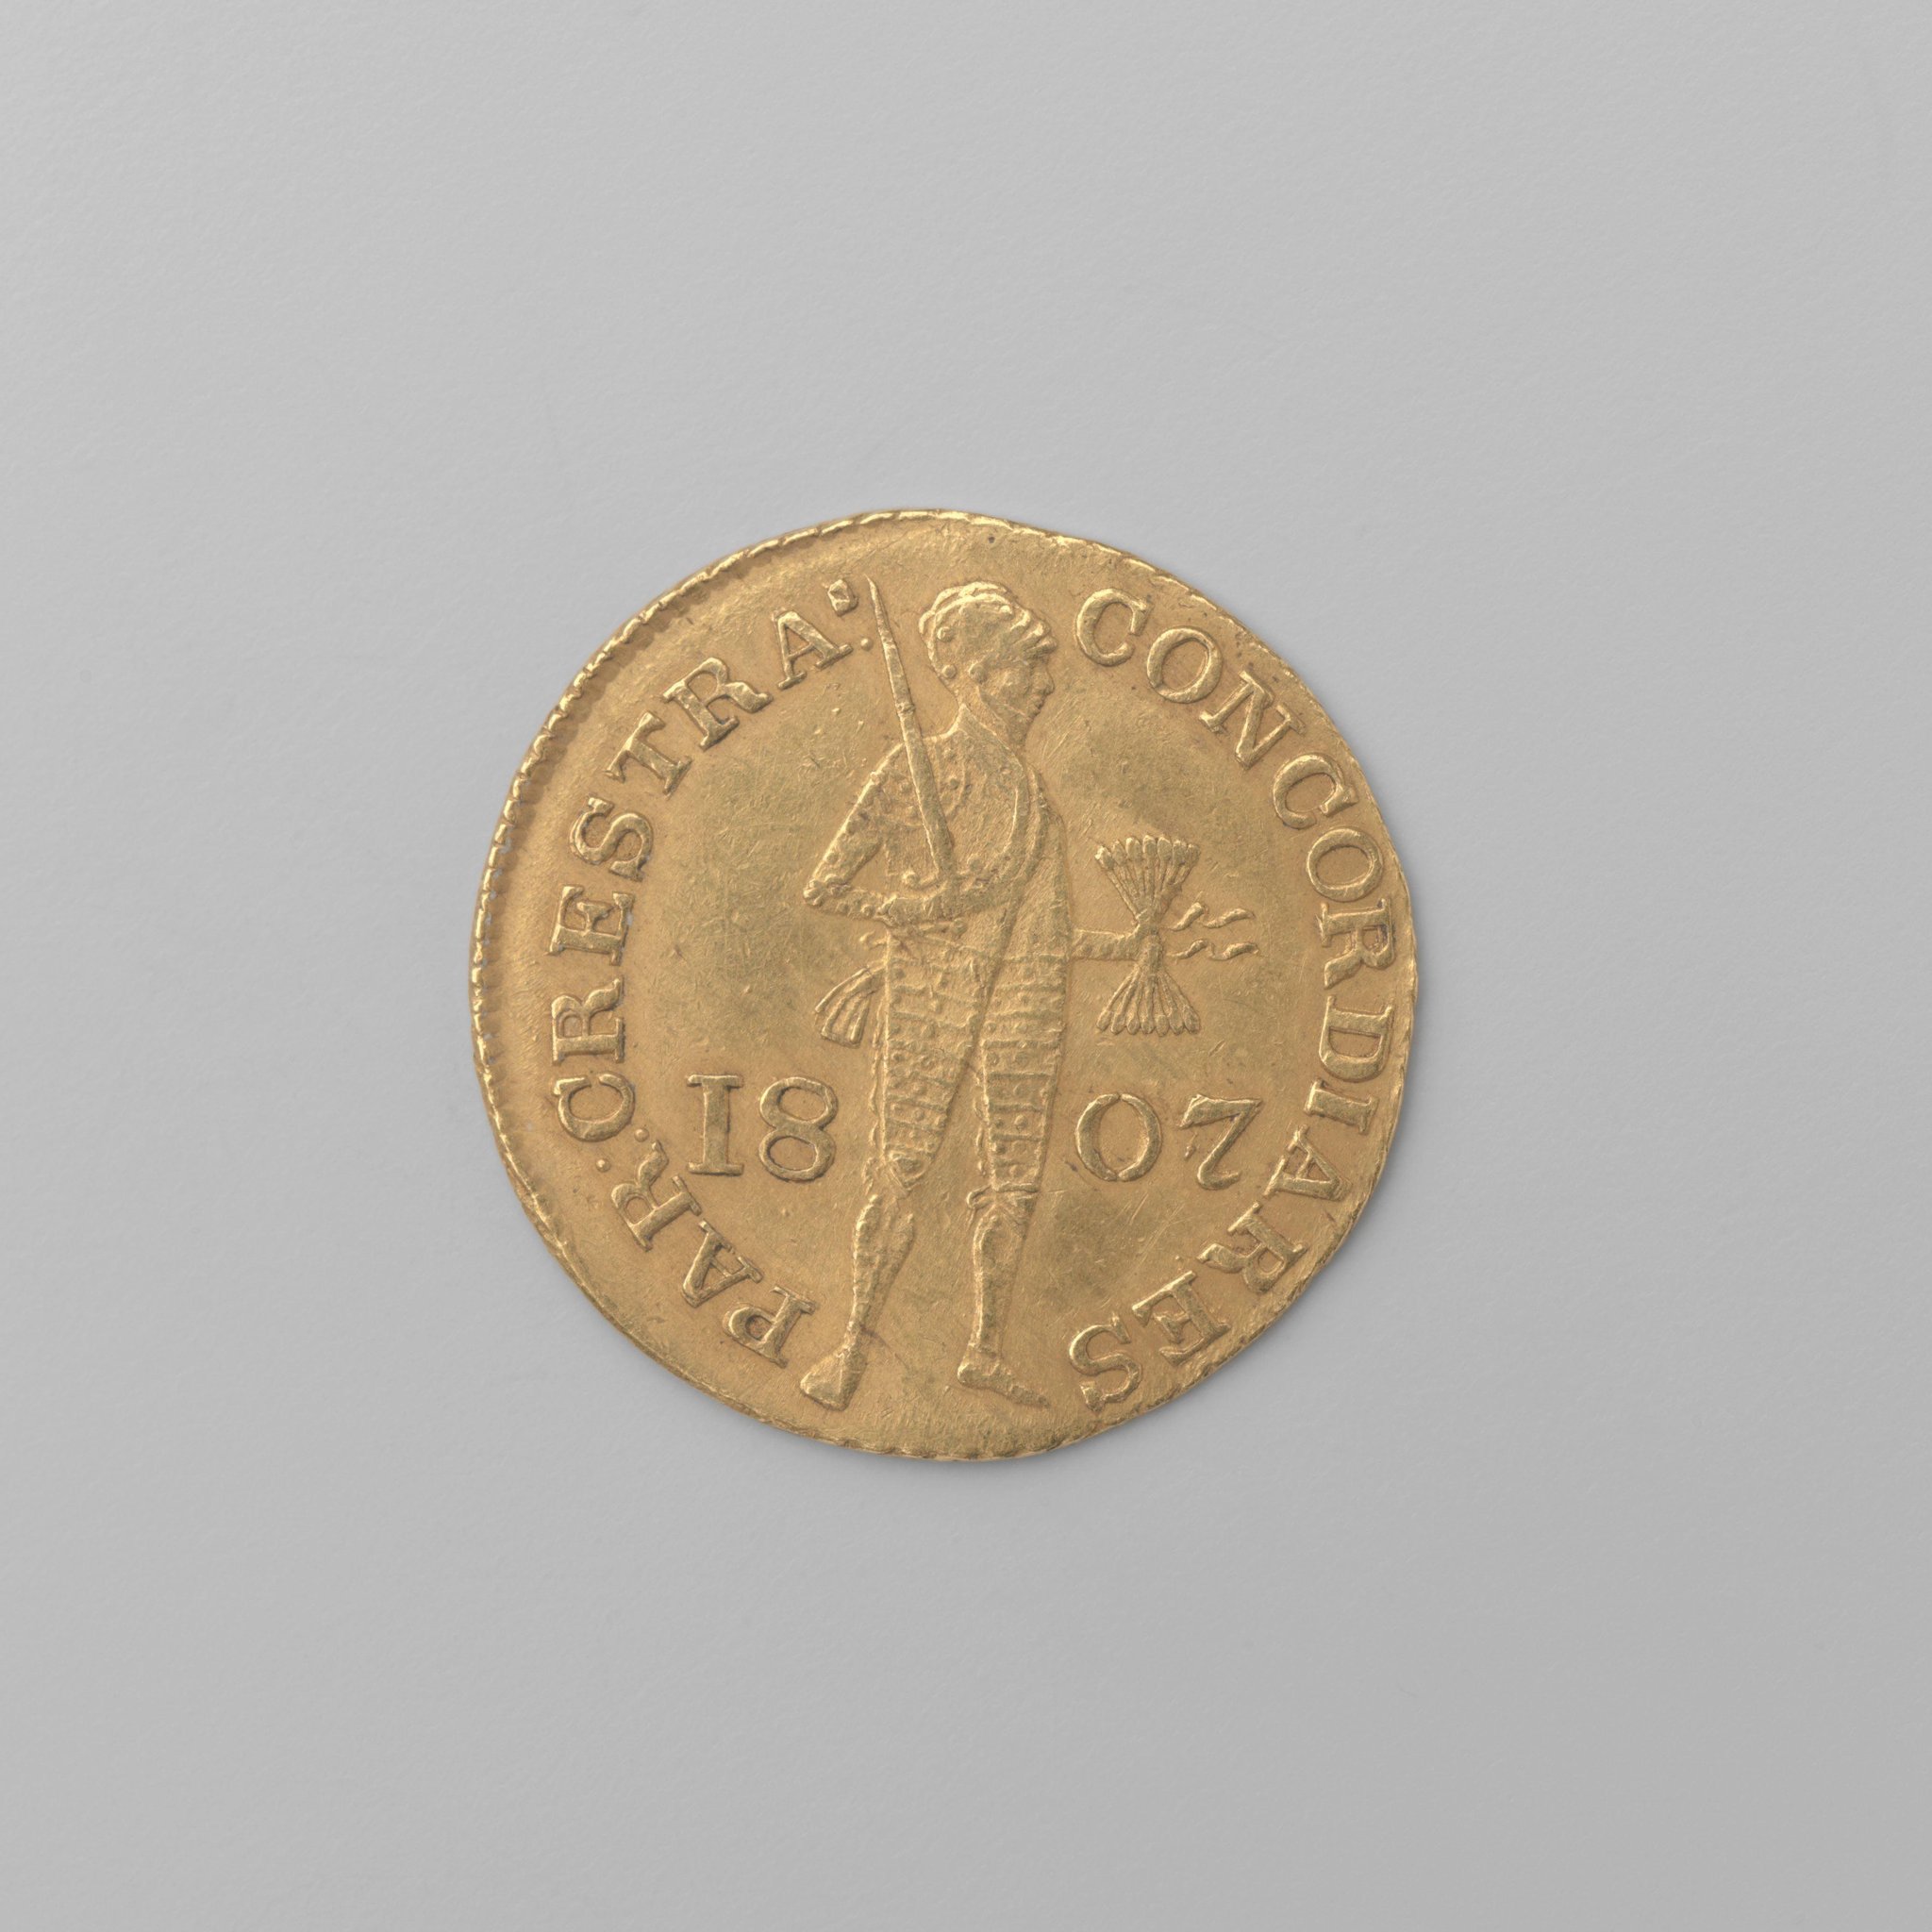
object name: coin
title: Koninkrijk Holland, dukaat op naam van Utrecht, 1807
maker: louis napoleon (king of holland)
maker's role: koning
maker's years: 1778-1846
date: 1807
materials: gold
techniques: striking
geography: utrecht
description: Gouden munt. Voorzijde: tussen jaartal staande ridder met zwaard en pijlenbundel. Keerzijde: in een versierd vierkant vijf-regelig opschrift. Kabelrand.